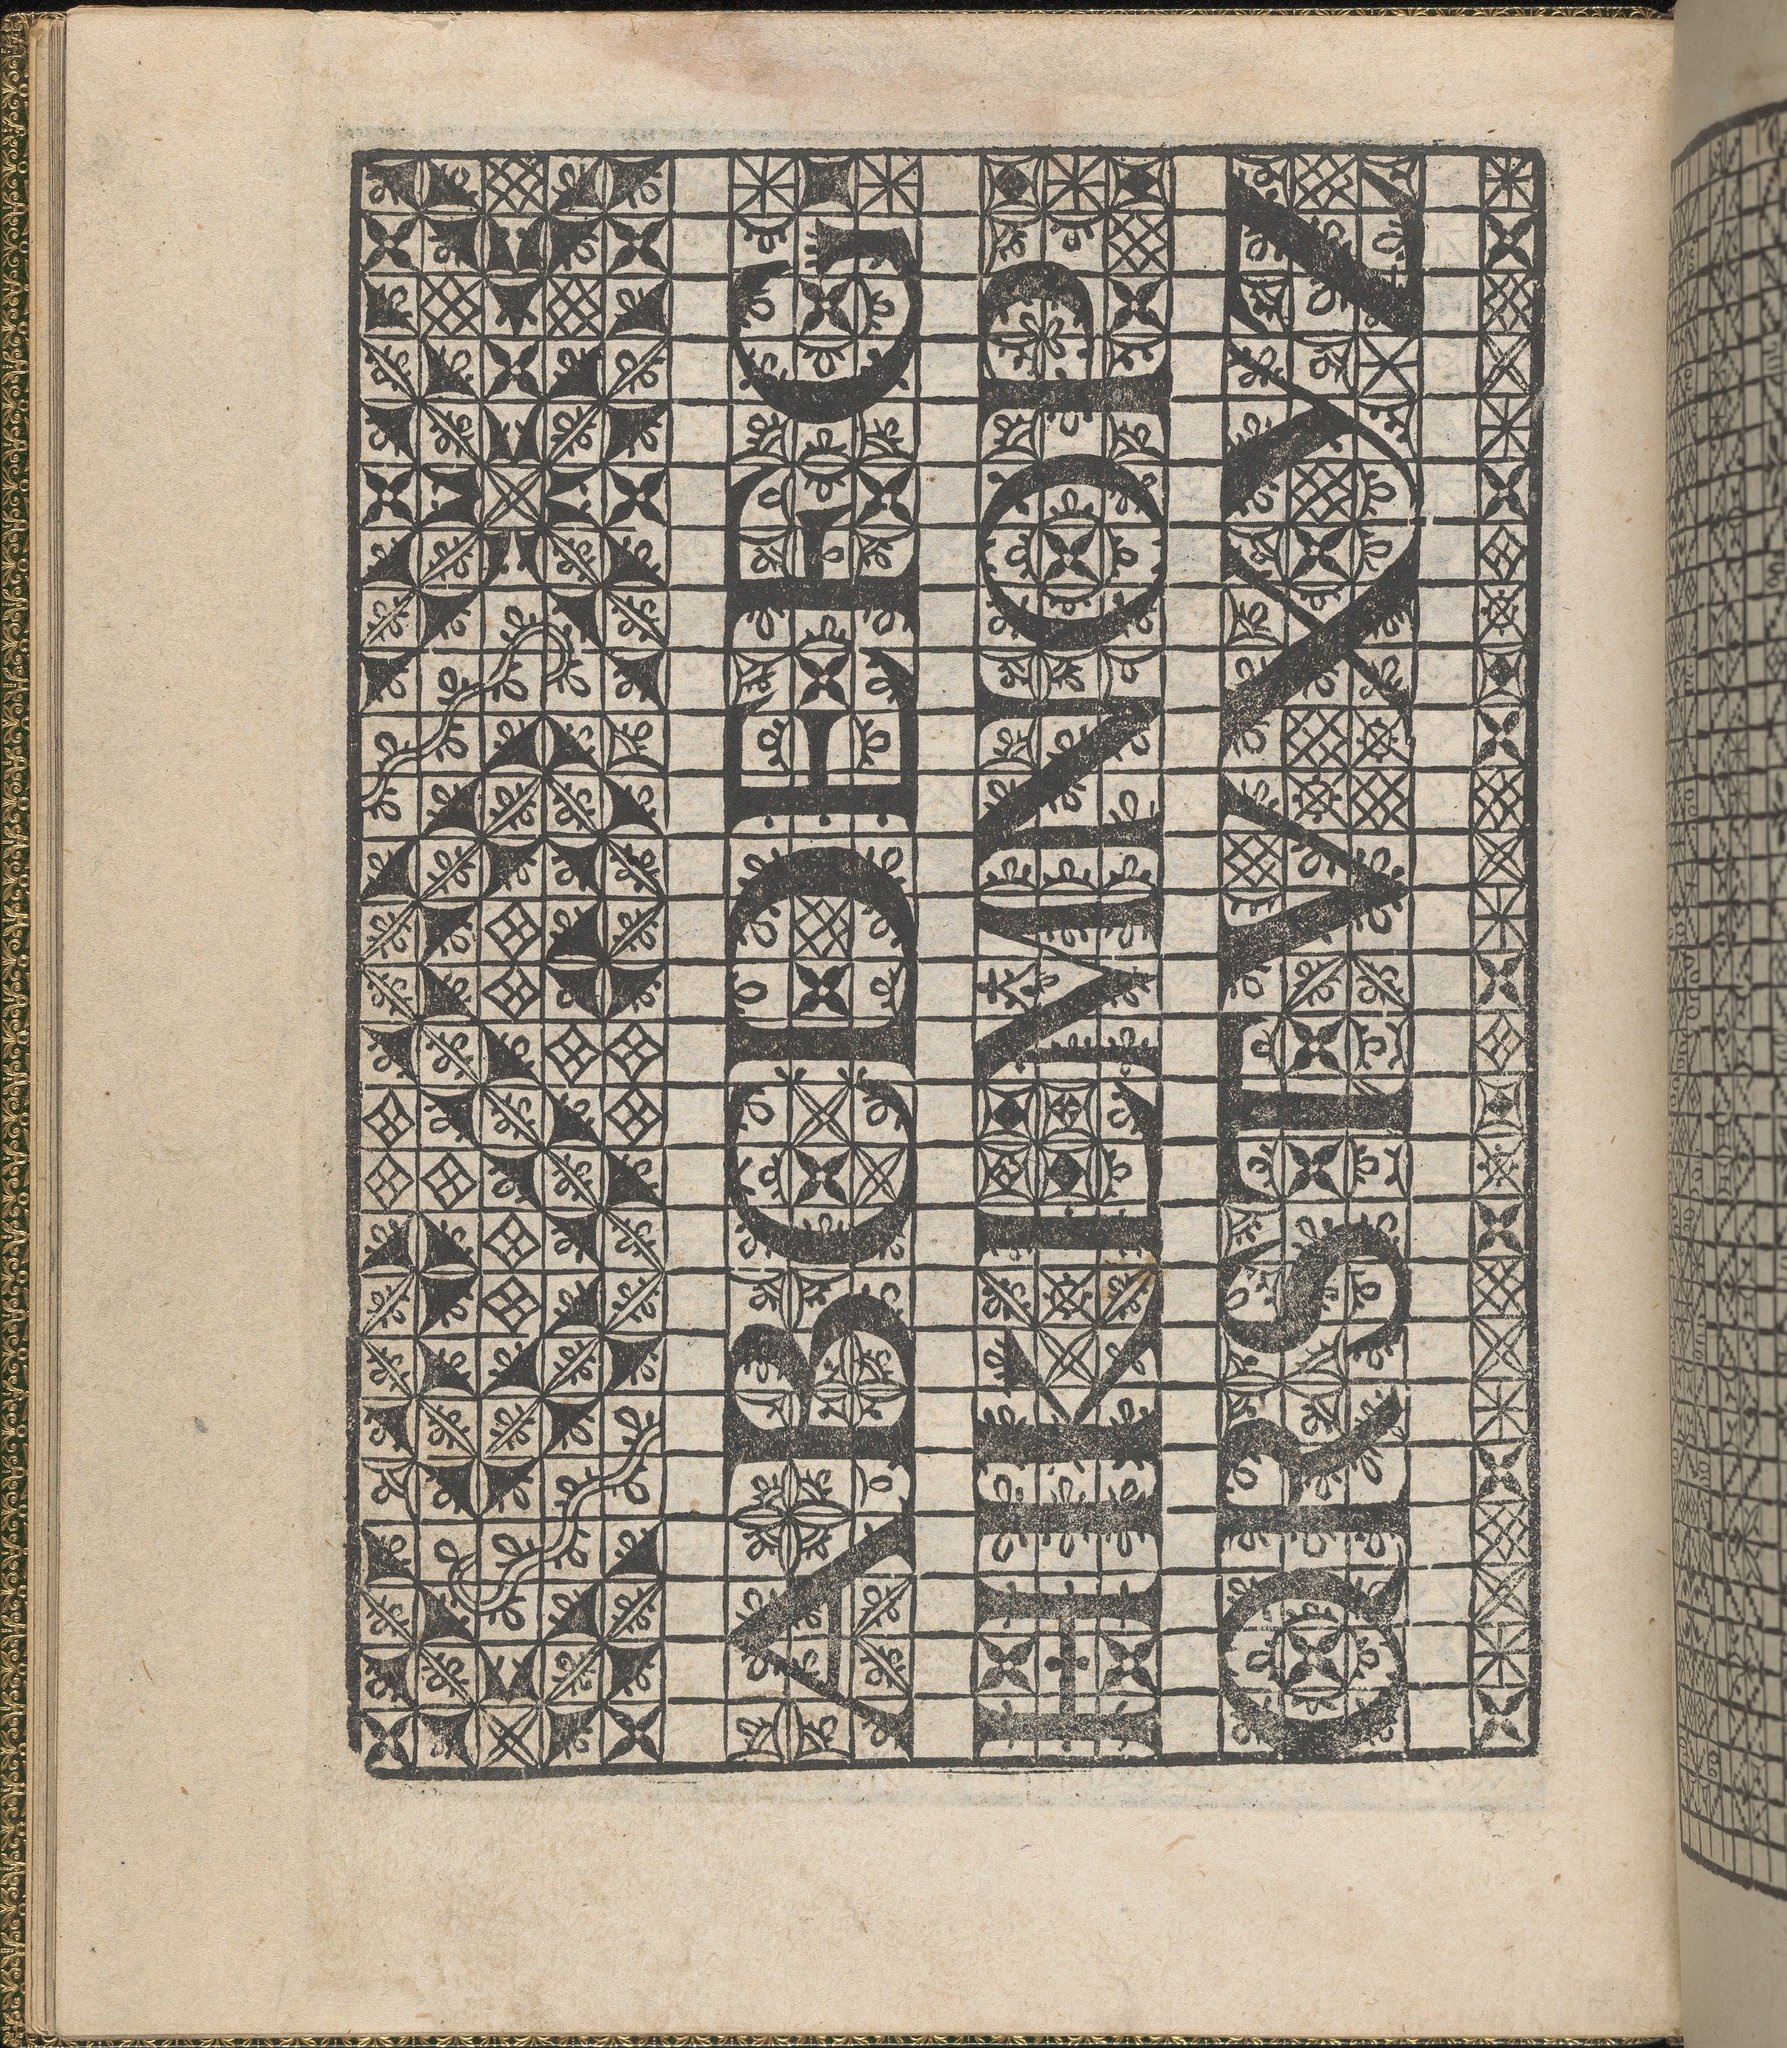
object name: book print ornament architecture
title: Giardineto novo di punti tagliati et gropposi per exercitio & ornamento delle donne (Venice 1554), page 20 (verso)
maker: matteo pagano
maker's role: publisher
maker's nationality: italian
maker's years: 1515-1588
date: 1554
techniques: woodcut